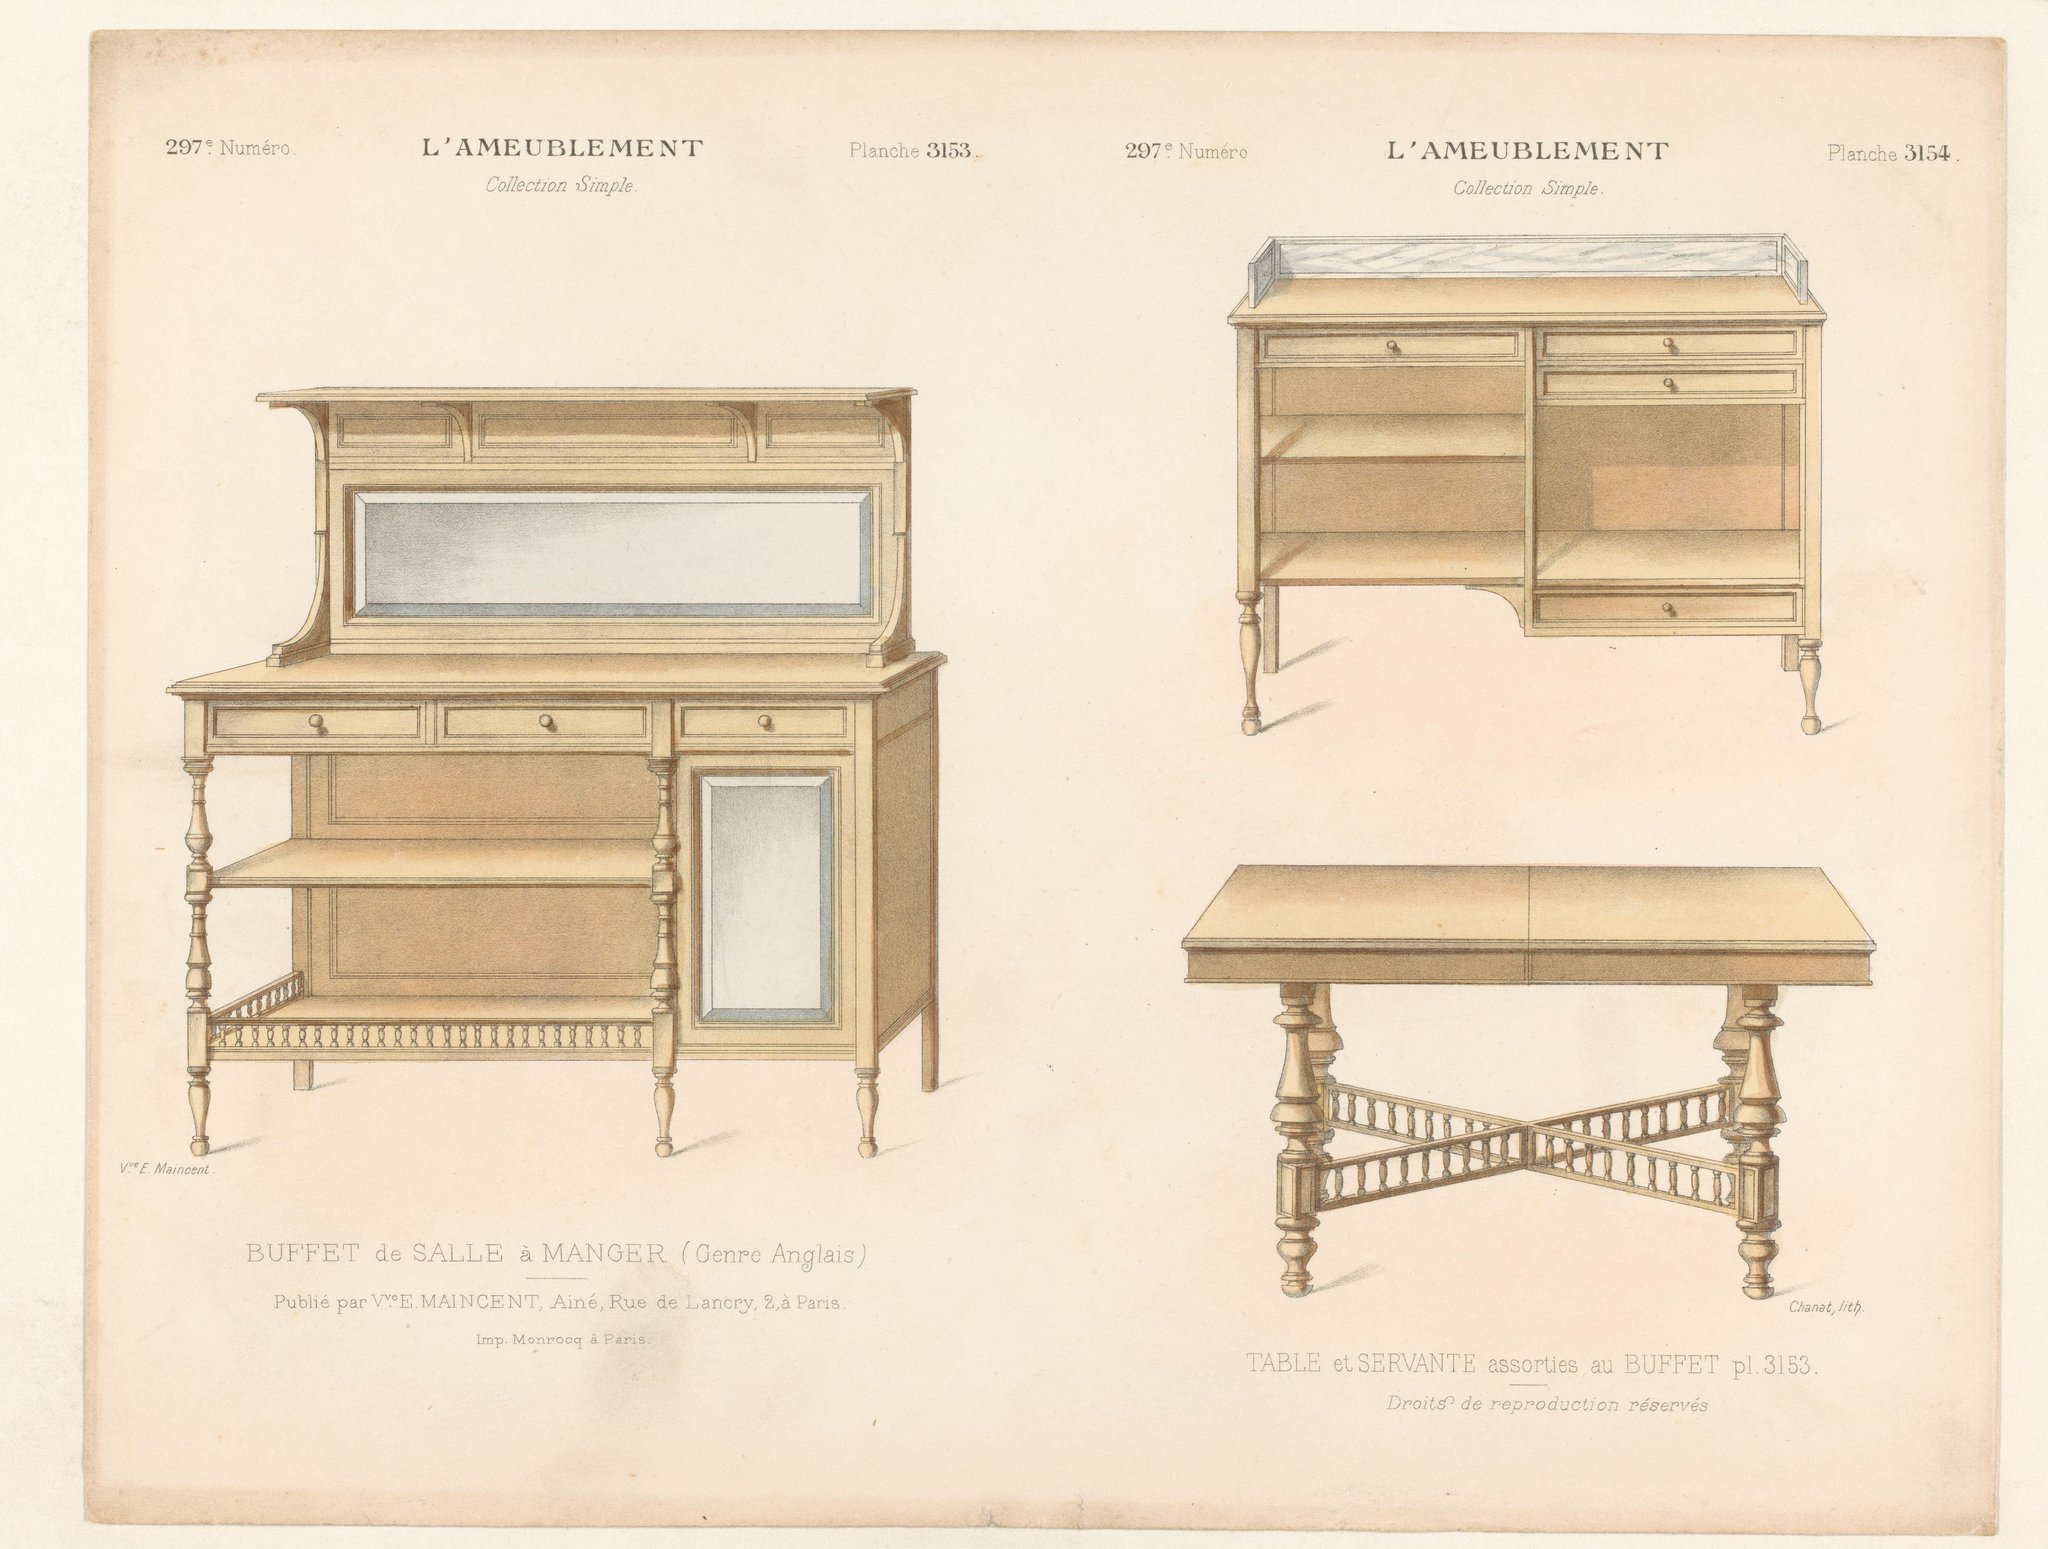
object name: print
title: Buffet de salle à manger (Genre Anglais) / Table et servante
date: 1895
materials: paper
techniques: hand coloring, lithograph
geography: paris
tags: furniture for storage, table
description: Een buffetkast, lage open kast en rechthoekige tafel, bestemd voor een eetkamer. Prent uit 297e Livraison.